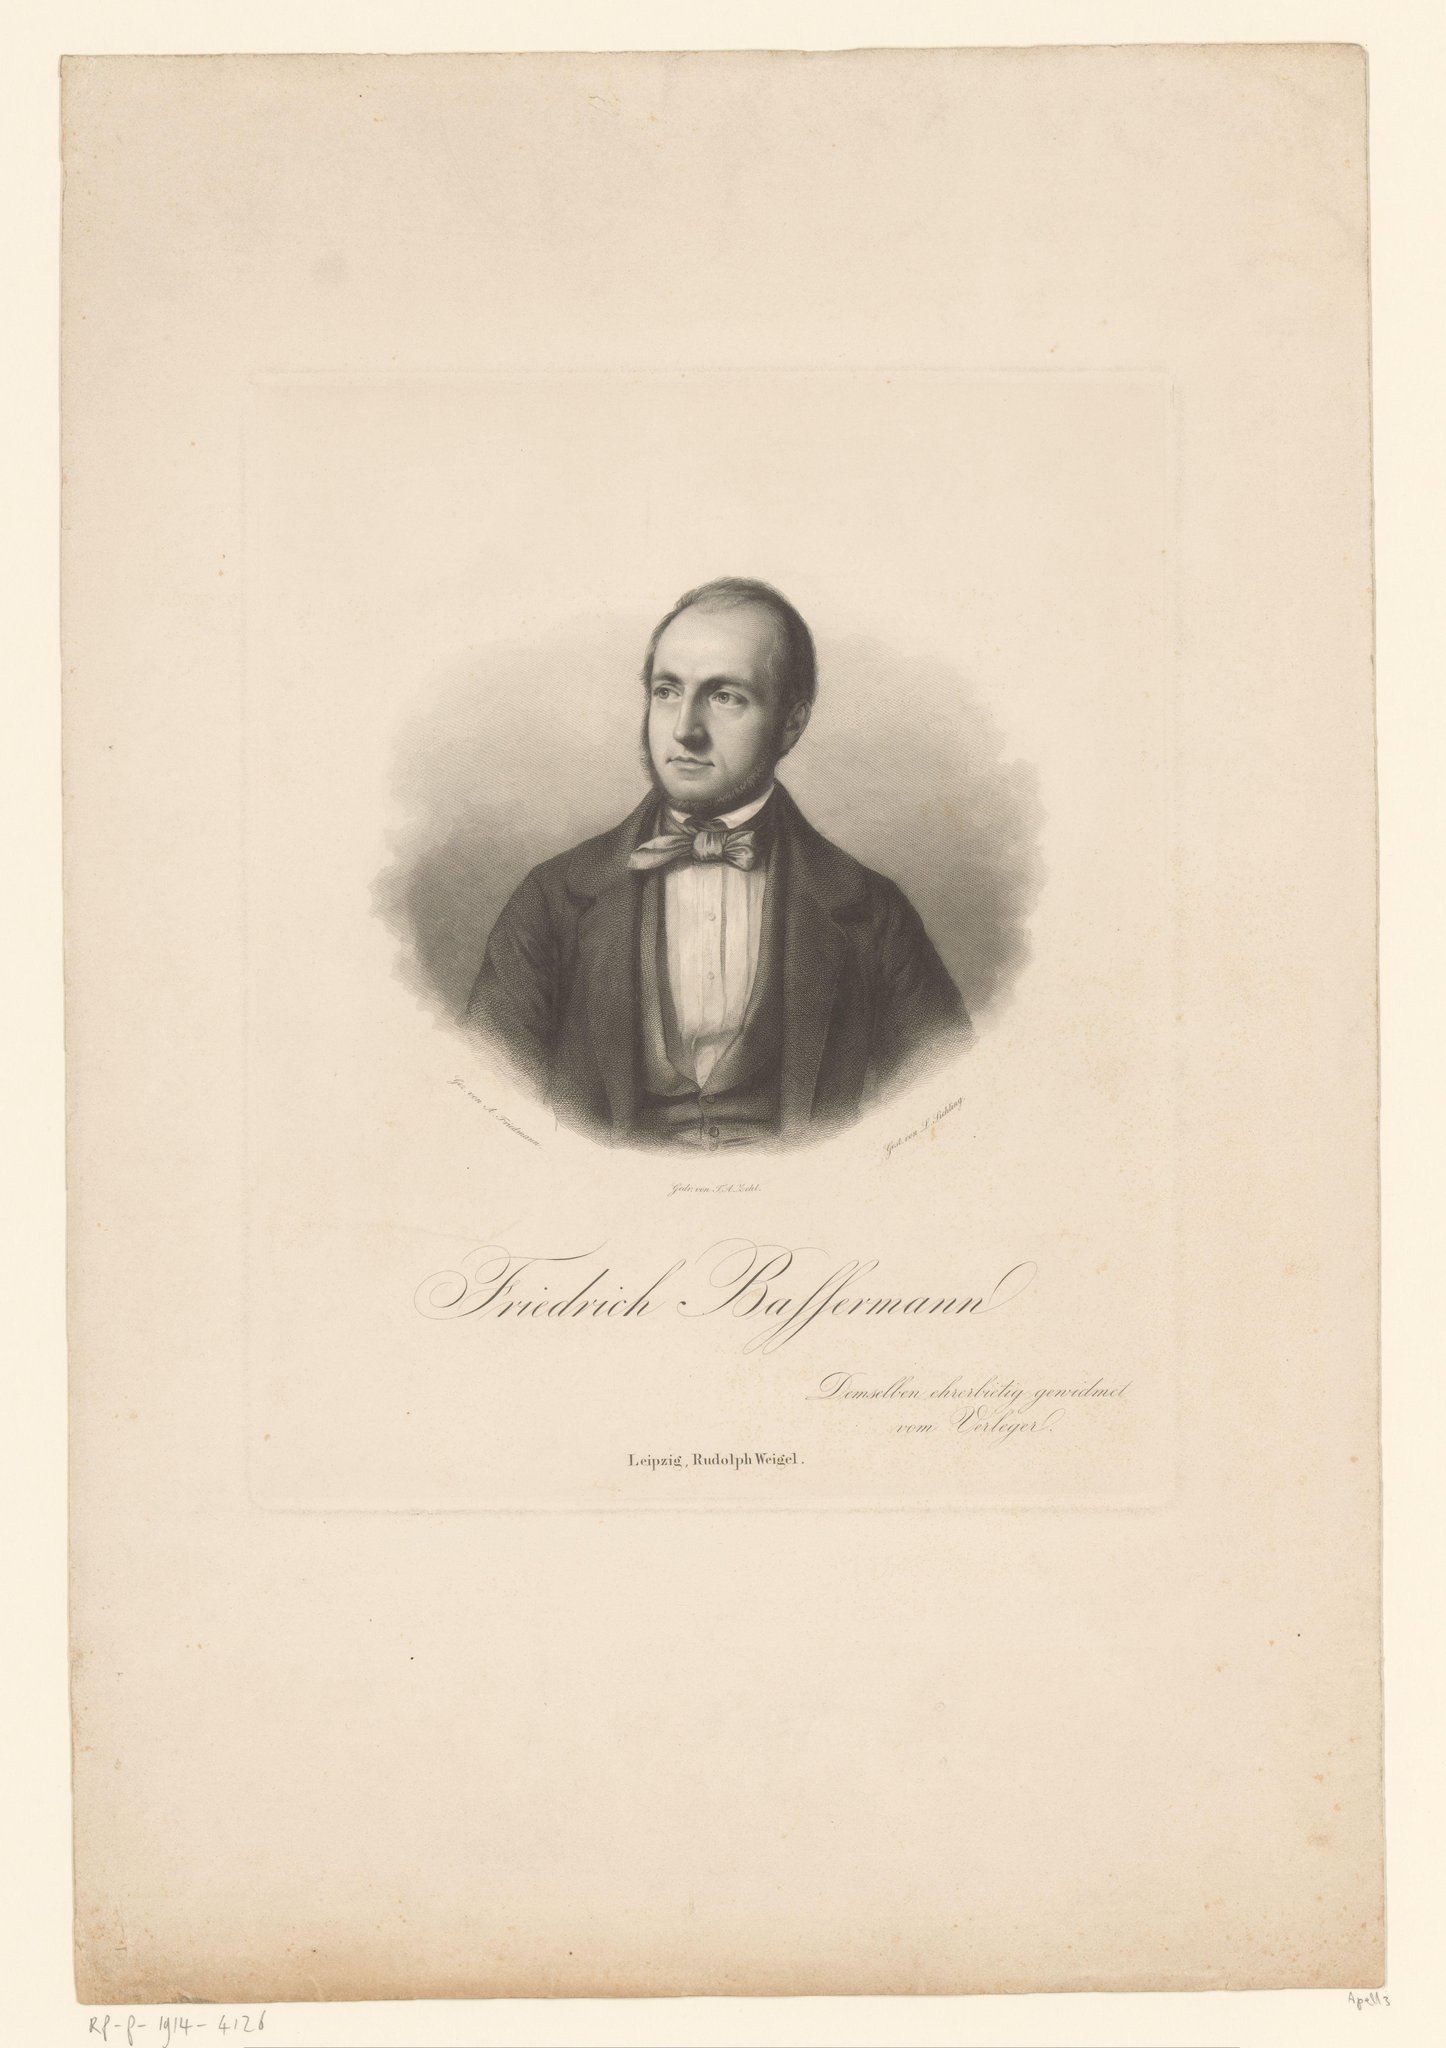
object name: print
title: Portret van Friedrich Bassermann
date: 1826-1863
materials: paper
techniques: engraving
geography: leipzig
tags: politician, historical persons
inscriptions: collector's mark: Lugt 2228